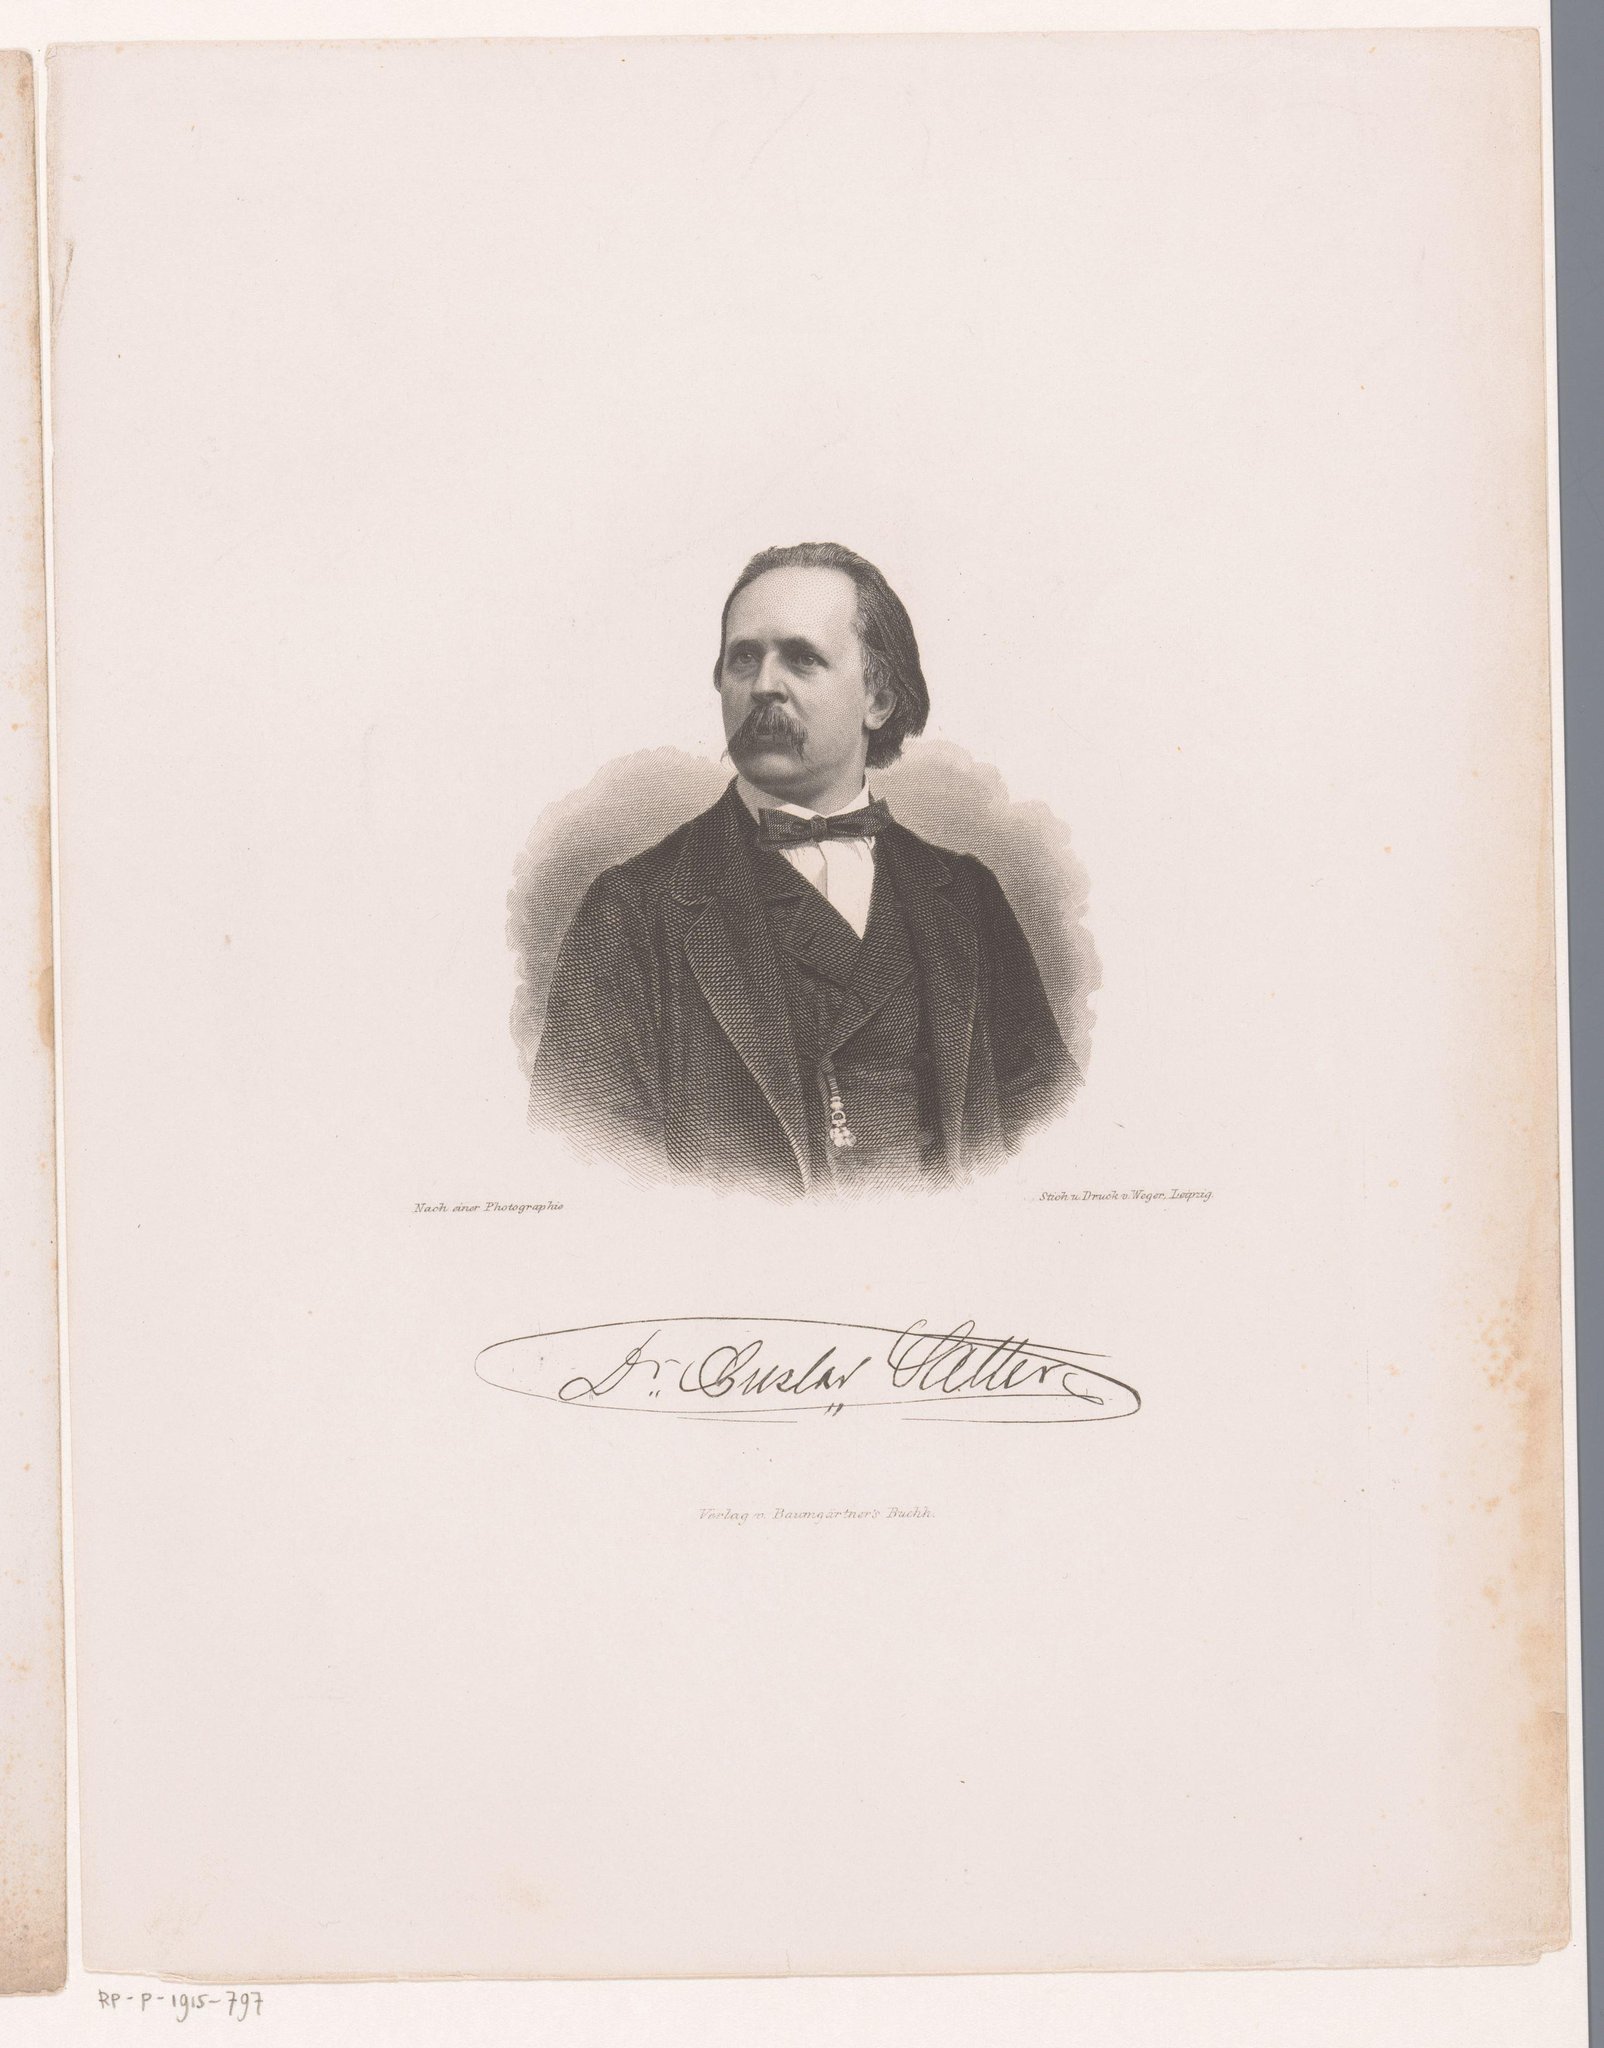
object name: print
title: Portret van Gustave Satter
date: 1875-1892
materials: paper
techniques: engraving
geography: leipzig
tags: historical persons, portrait of composer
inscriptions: collector's mark: Lugt 2228